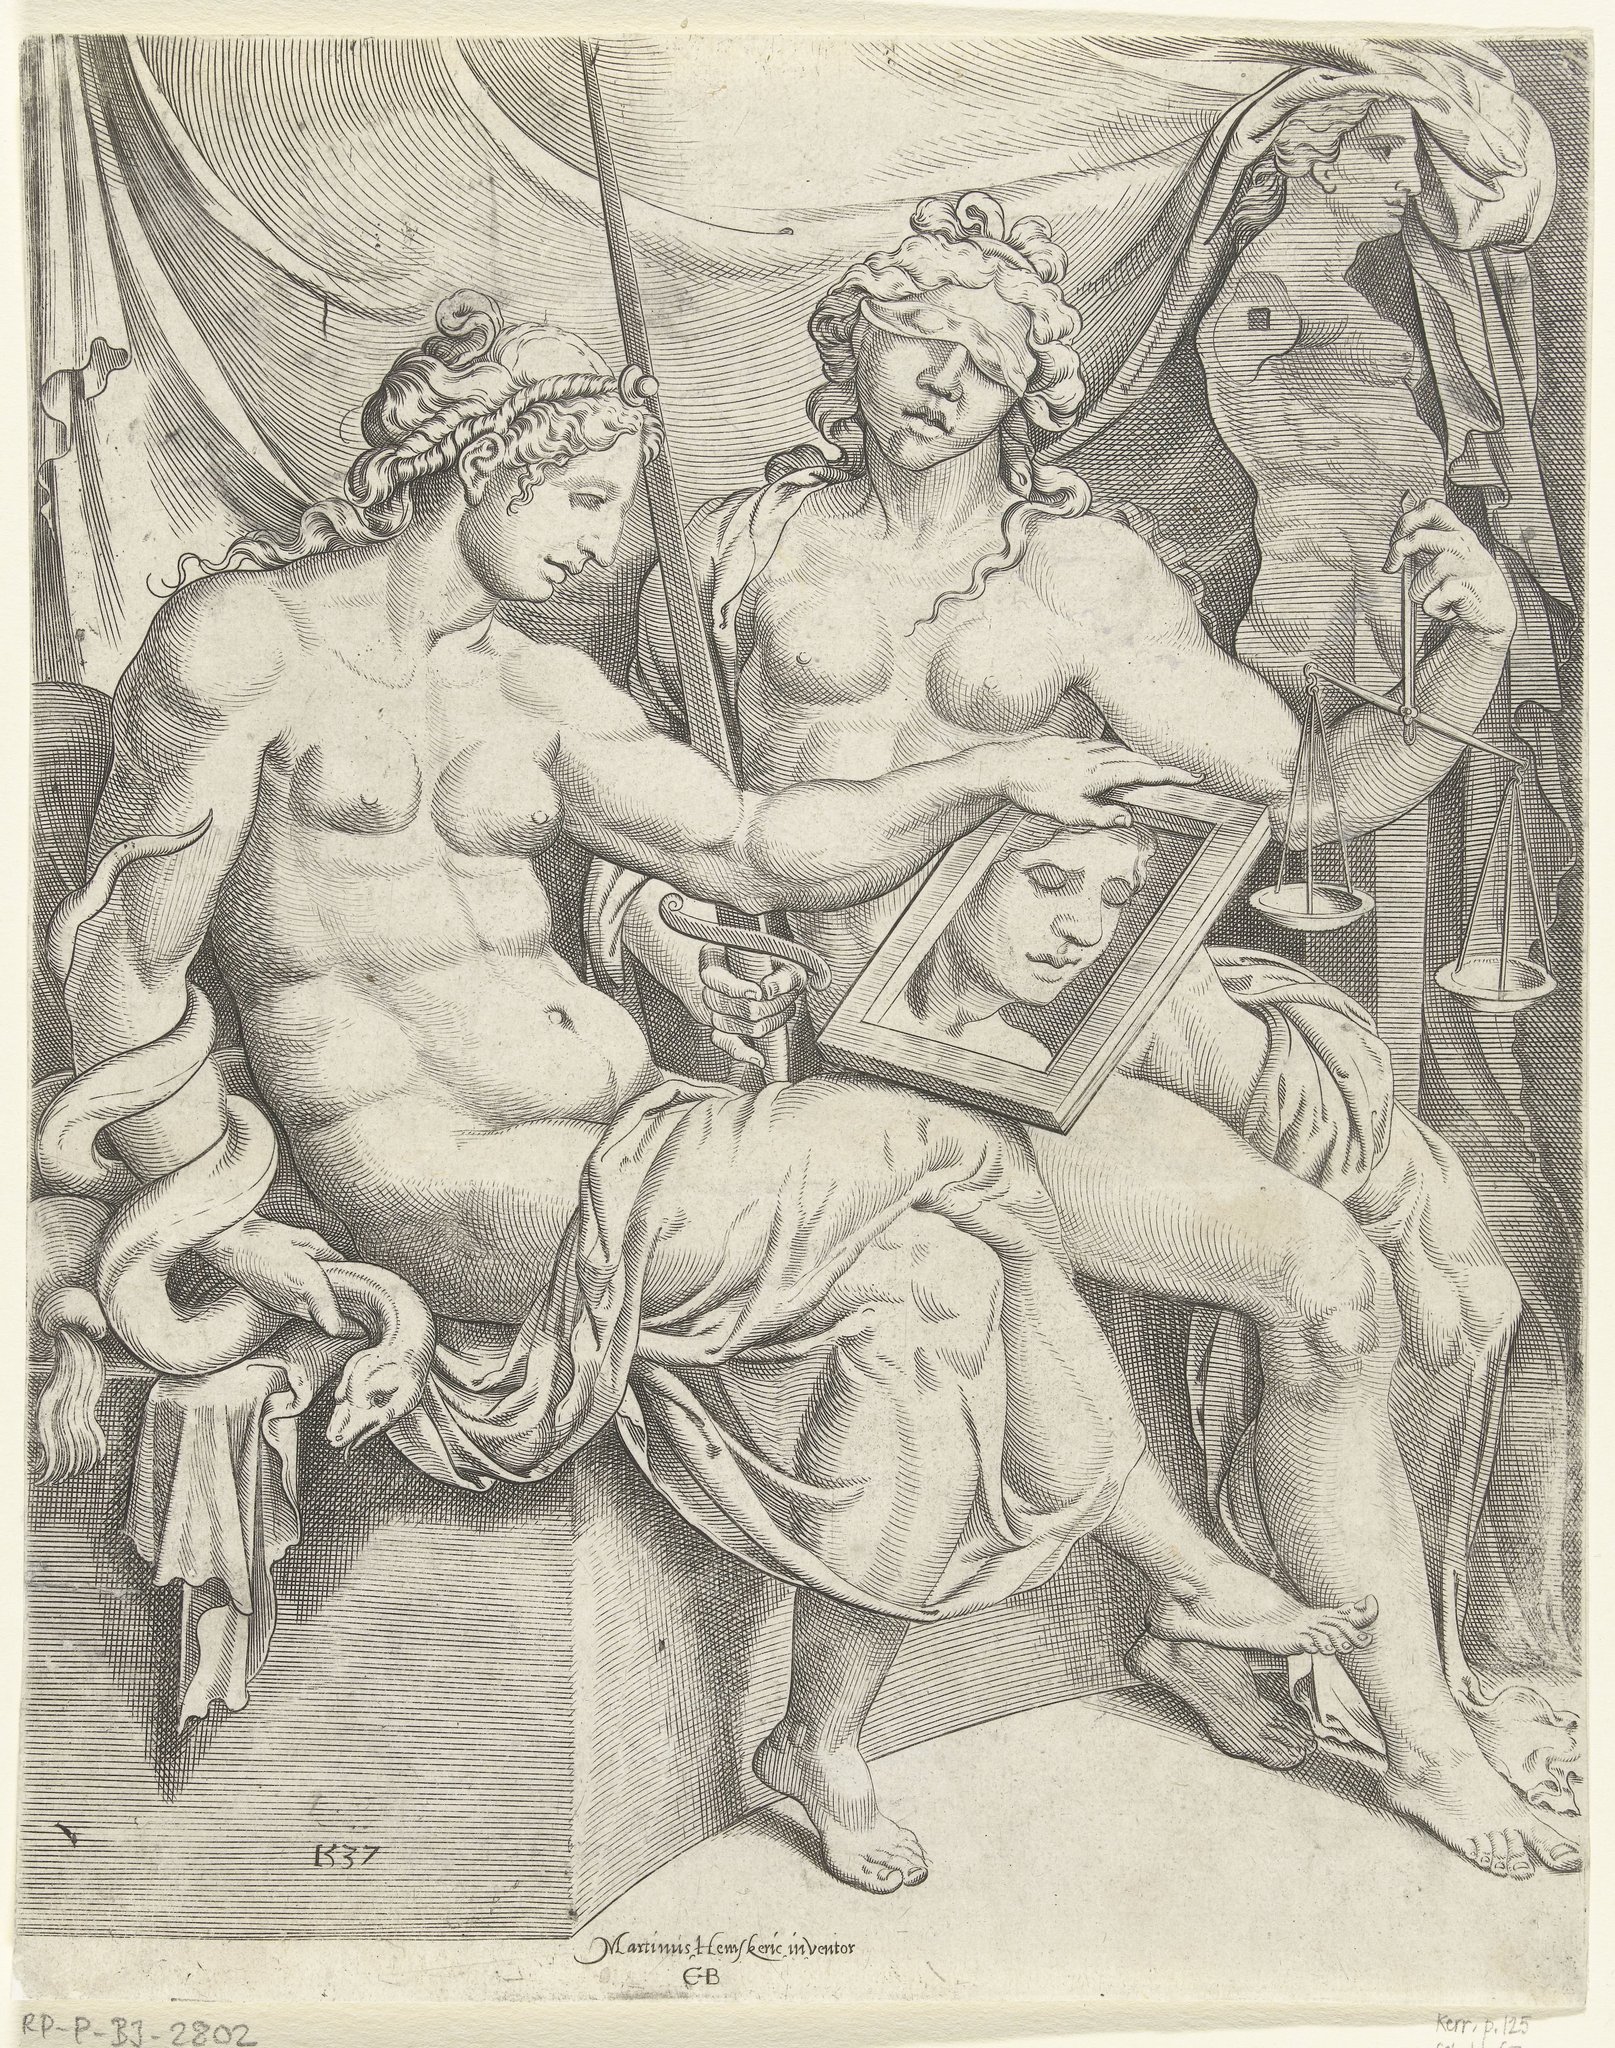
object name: print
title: Voorzichtigheid en Rechtvaardigheid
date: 1537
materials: paper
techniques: engraving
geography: antwerp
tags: justice, 'justitia'; 'giustitia divina' (ripa) ~ one of the four cardinal virtues, prudence, 'prudentia'; 'prudenza' (ripa) ~ one of the four cardinal virtues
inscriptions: collector's mark: Lugt 2228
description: Voorzichtigheid (Prudentia) en Rechtvaardigheid (Justitia) zitten naast elkaar op een stenen blok. Prudentia bekijkt zich in de spiegel, een slang windt zich om haar arm. Justitia is geblinddoekt en houdt een zwaard en een wegschaal in haar handen.